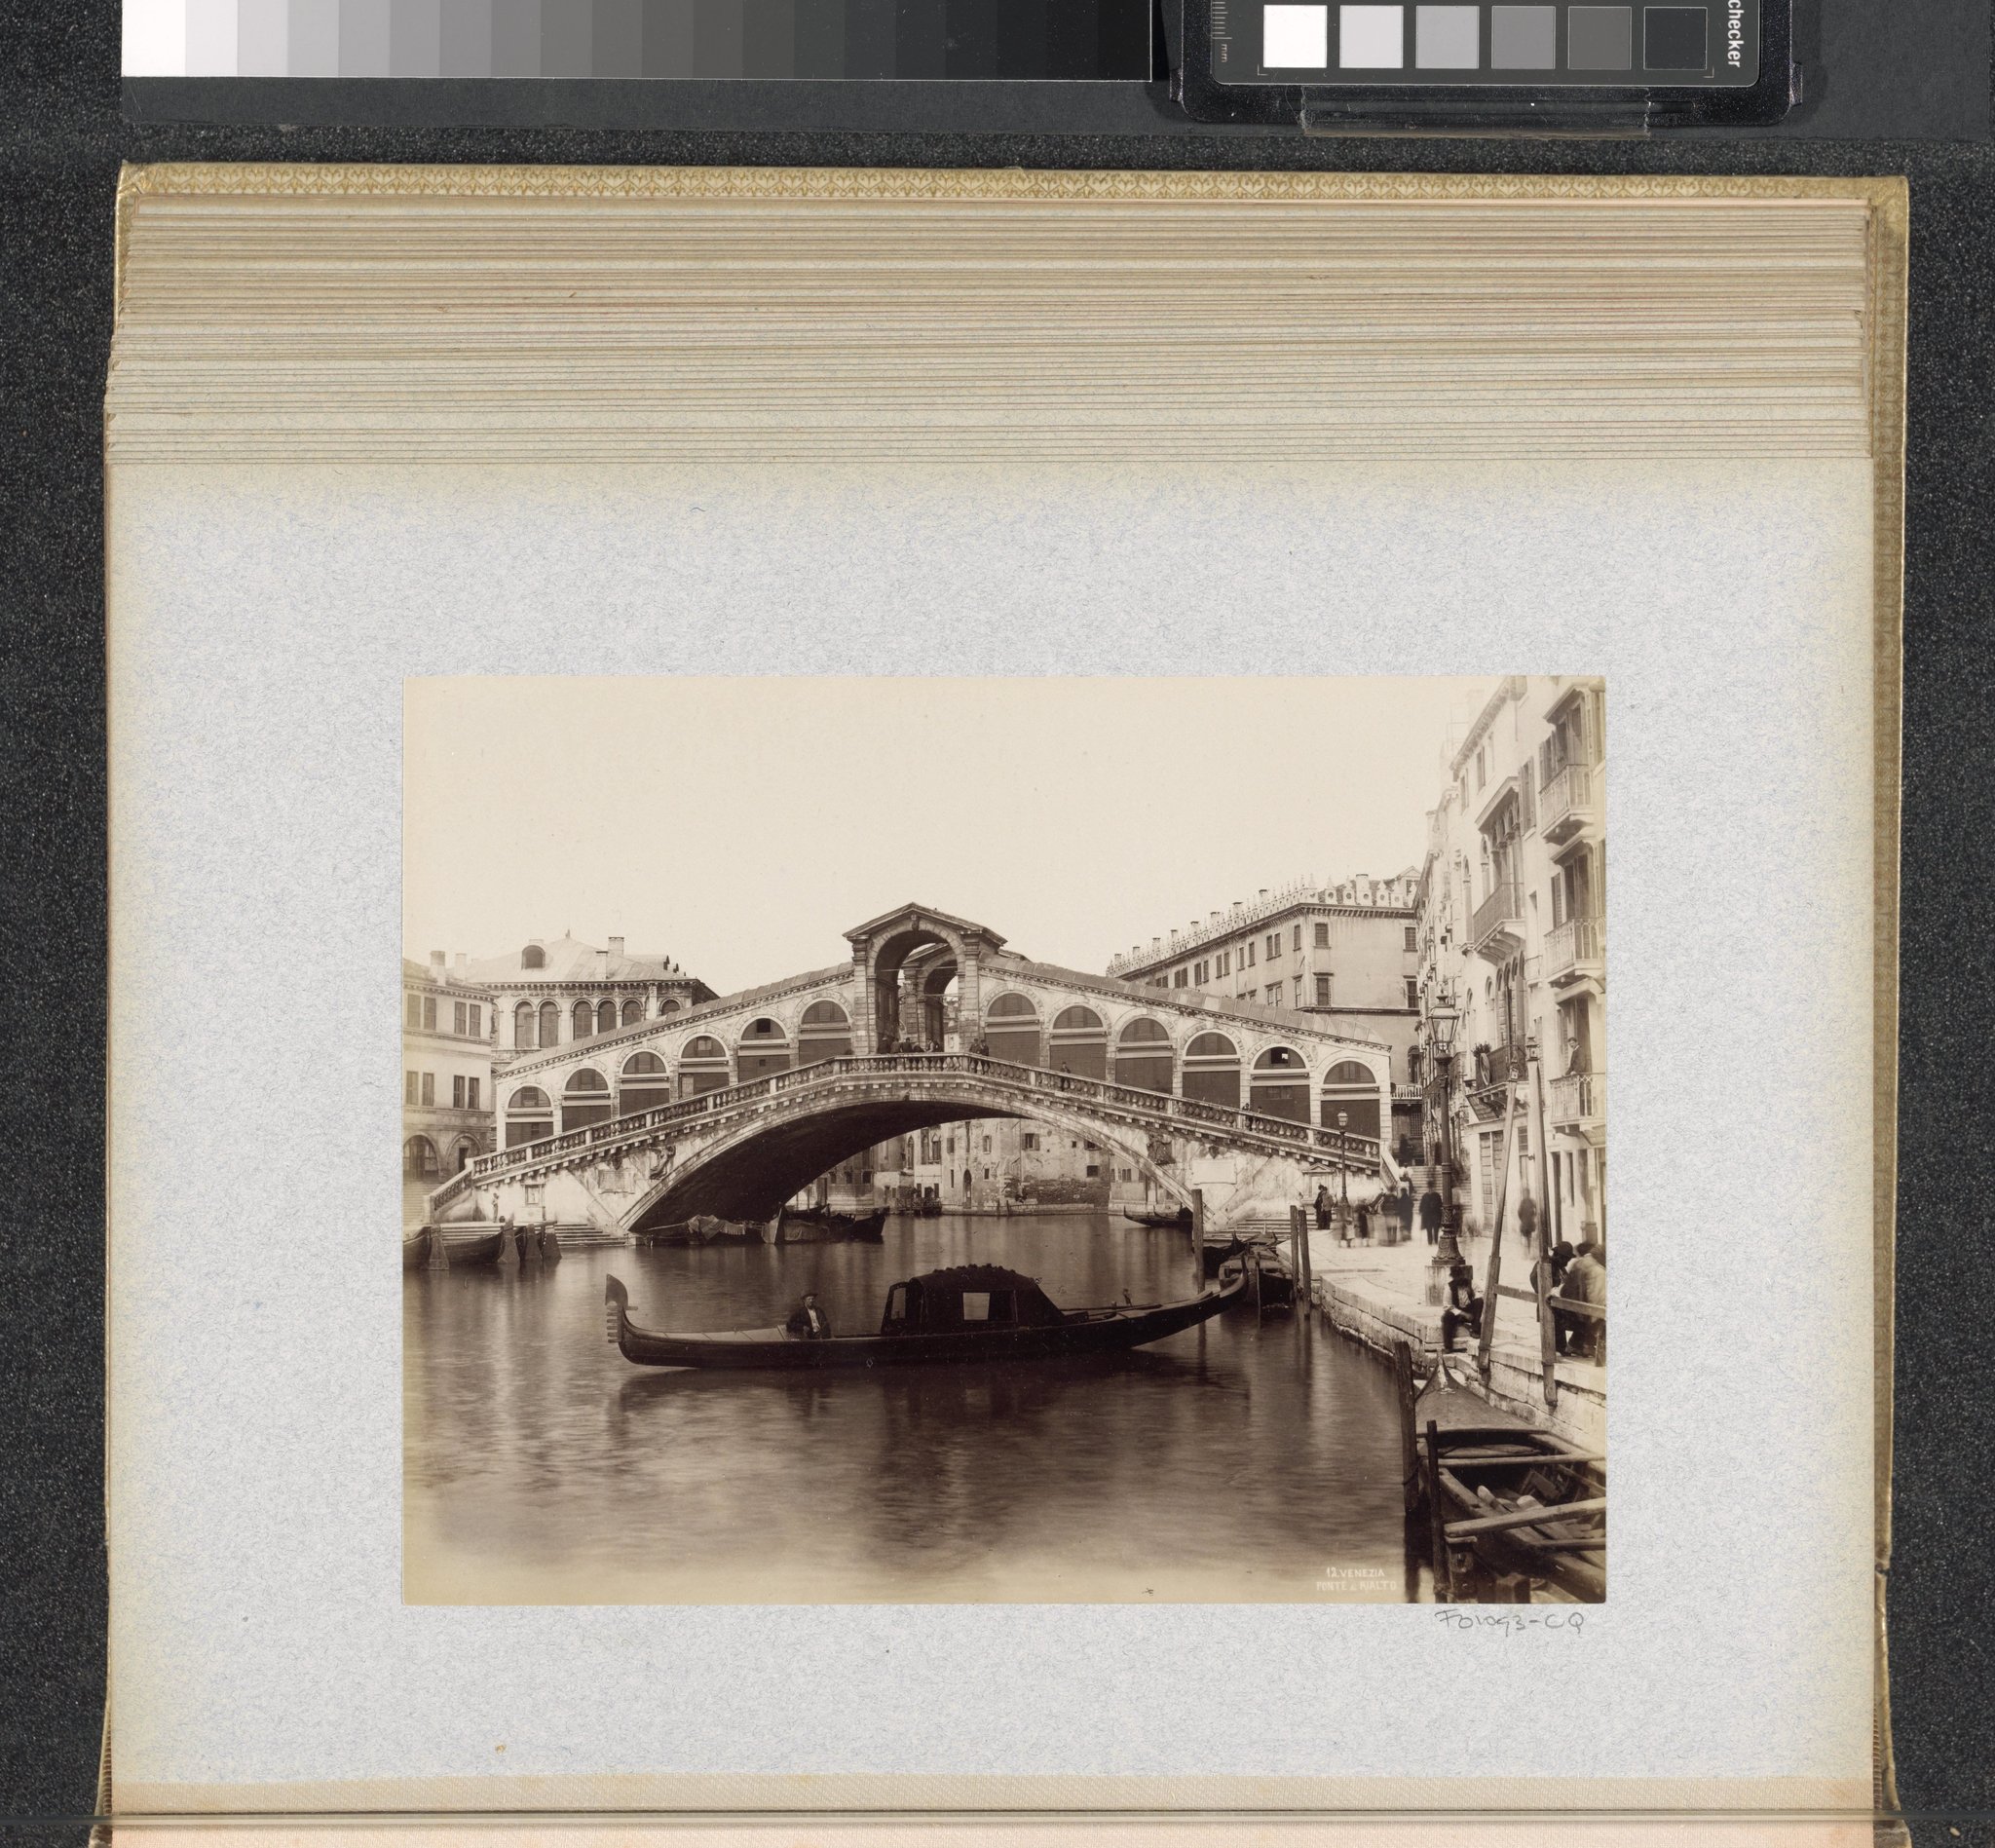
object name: photograph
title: Rialtobrug over het Canal Grande in Venetië met op de voorgrond een gondel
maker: Anonymous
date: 1870-1890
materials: paper, photographic support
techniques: albumen print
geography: venice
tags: bridge in city across river, canal, etc., gondola, venice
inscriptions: negative number: ‘12’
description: Onderdeel van Reisalbum met foto's van bezienswaardigheden in Genua, Florence en Venetië.